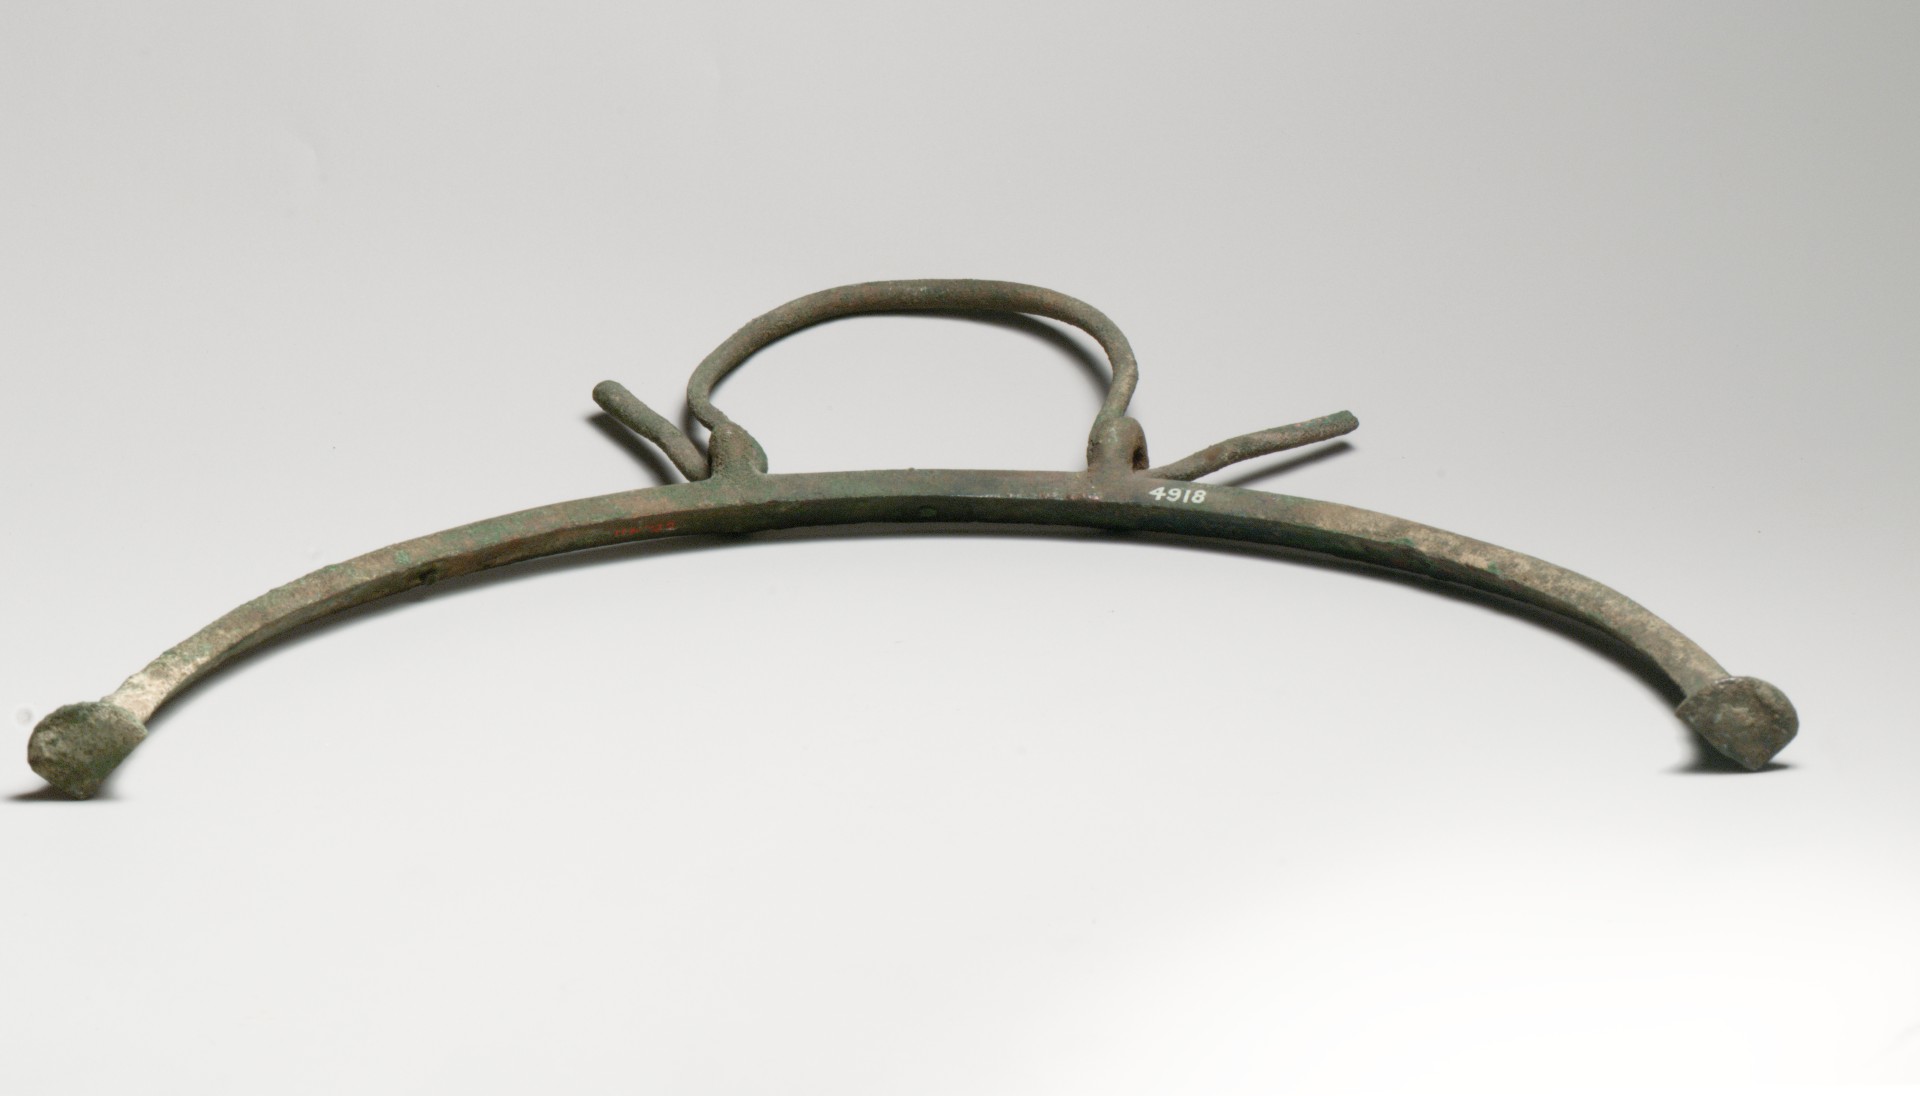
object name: handle of a bowl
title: Handle, swinging, of a bowl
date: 7000 BCE-330 CE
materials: bronze